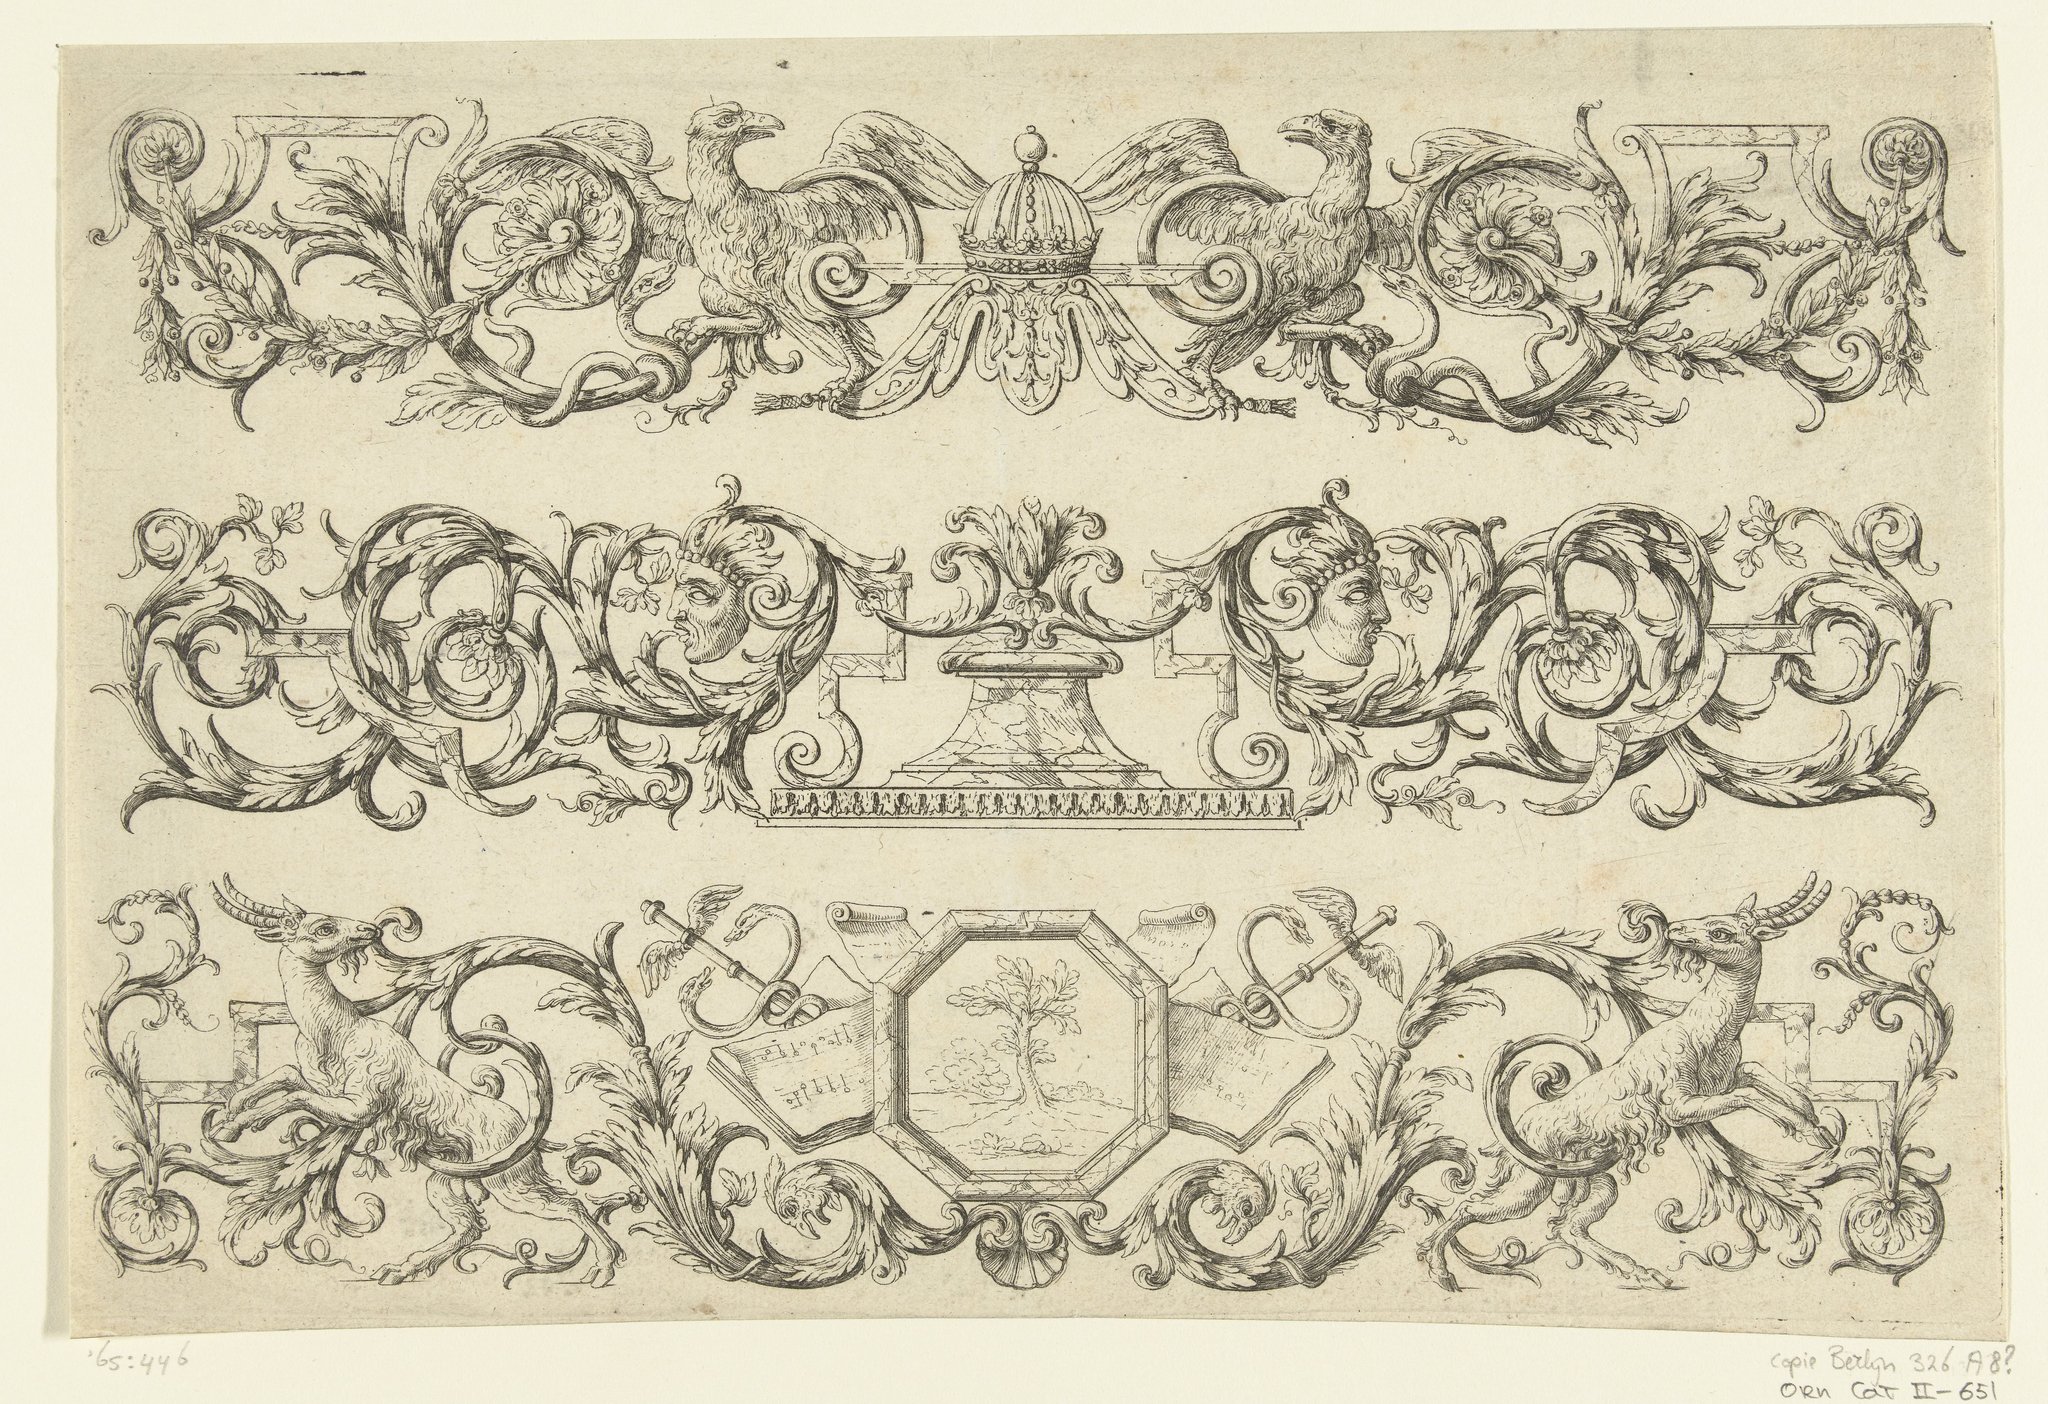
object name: print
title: Drie friezen van ranken bestaand uit bladeren, rolwerk en guirlandes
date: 1670-1693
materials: paper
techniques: etching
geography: france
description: Tussen de ranken bevinden zich adelaars, maskers en geiten. In het midden staan van boven naar beneden: een gesloten kroon, een offeraltaar en een achthoekige medaillon met een boom.